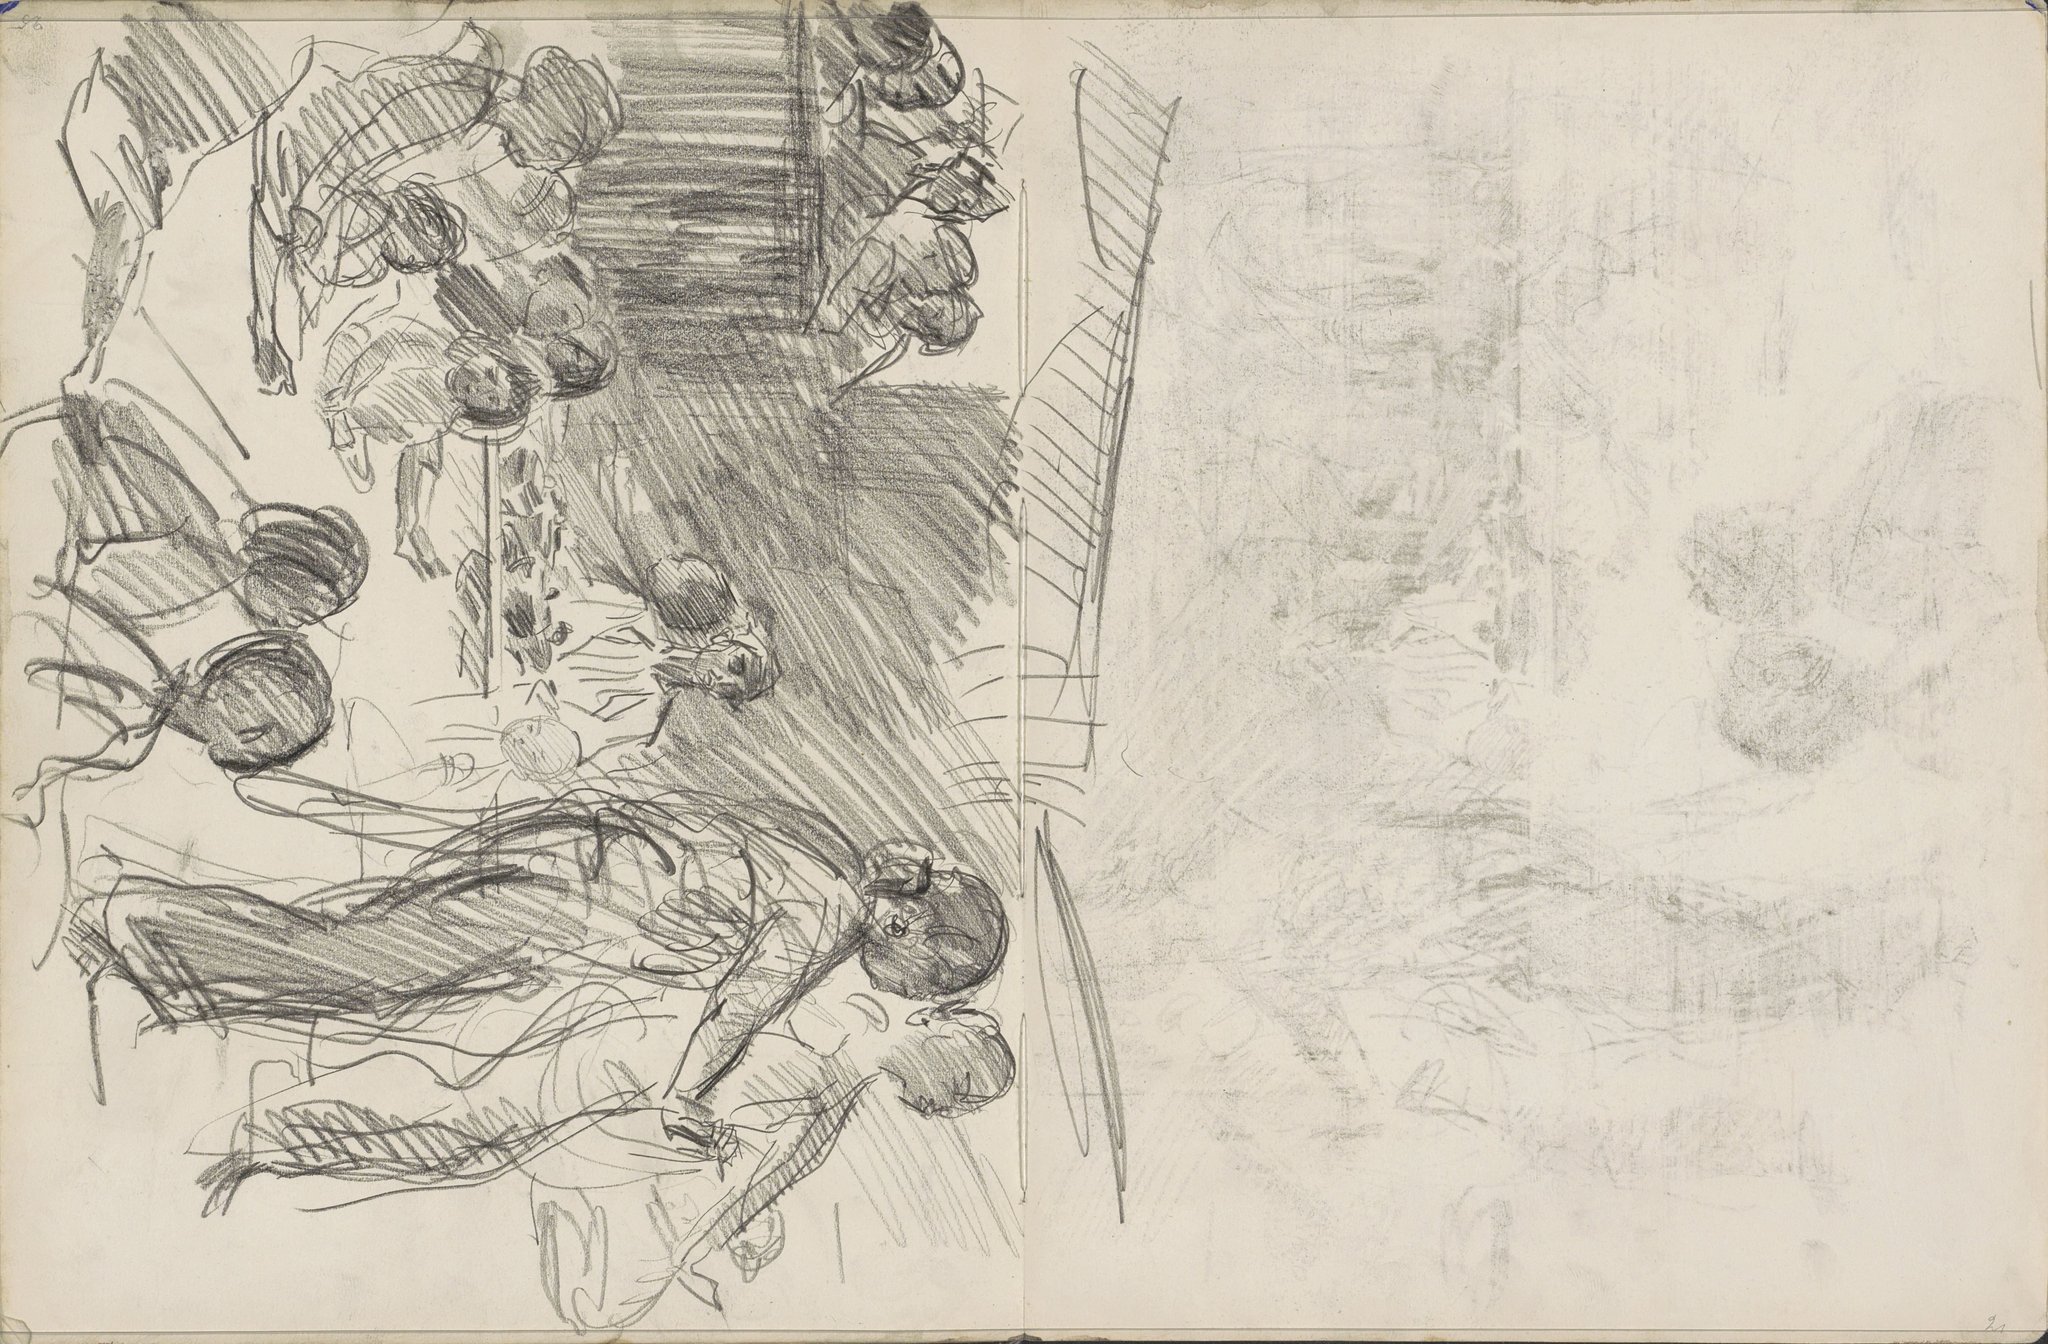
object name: sketchbook leaf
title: Toeschouwers bij danseressen en een gamelanorkest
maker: isaac israels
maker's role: draughtsman, painter, print maker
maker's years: 1865-1934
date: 1921-1922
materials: chalk, paper, pencil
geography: dutch east indies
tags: asiatic races and peoples, percussion instruments, the audience ~ art performance, female dancer, dutch east indies, the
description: Blad 20 verso en blad 21 recto uit schetsboek XIX met 22 bladen.